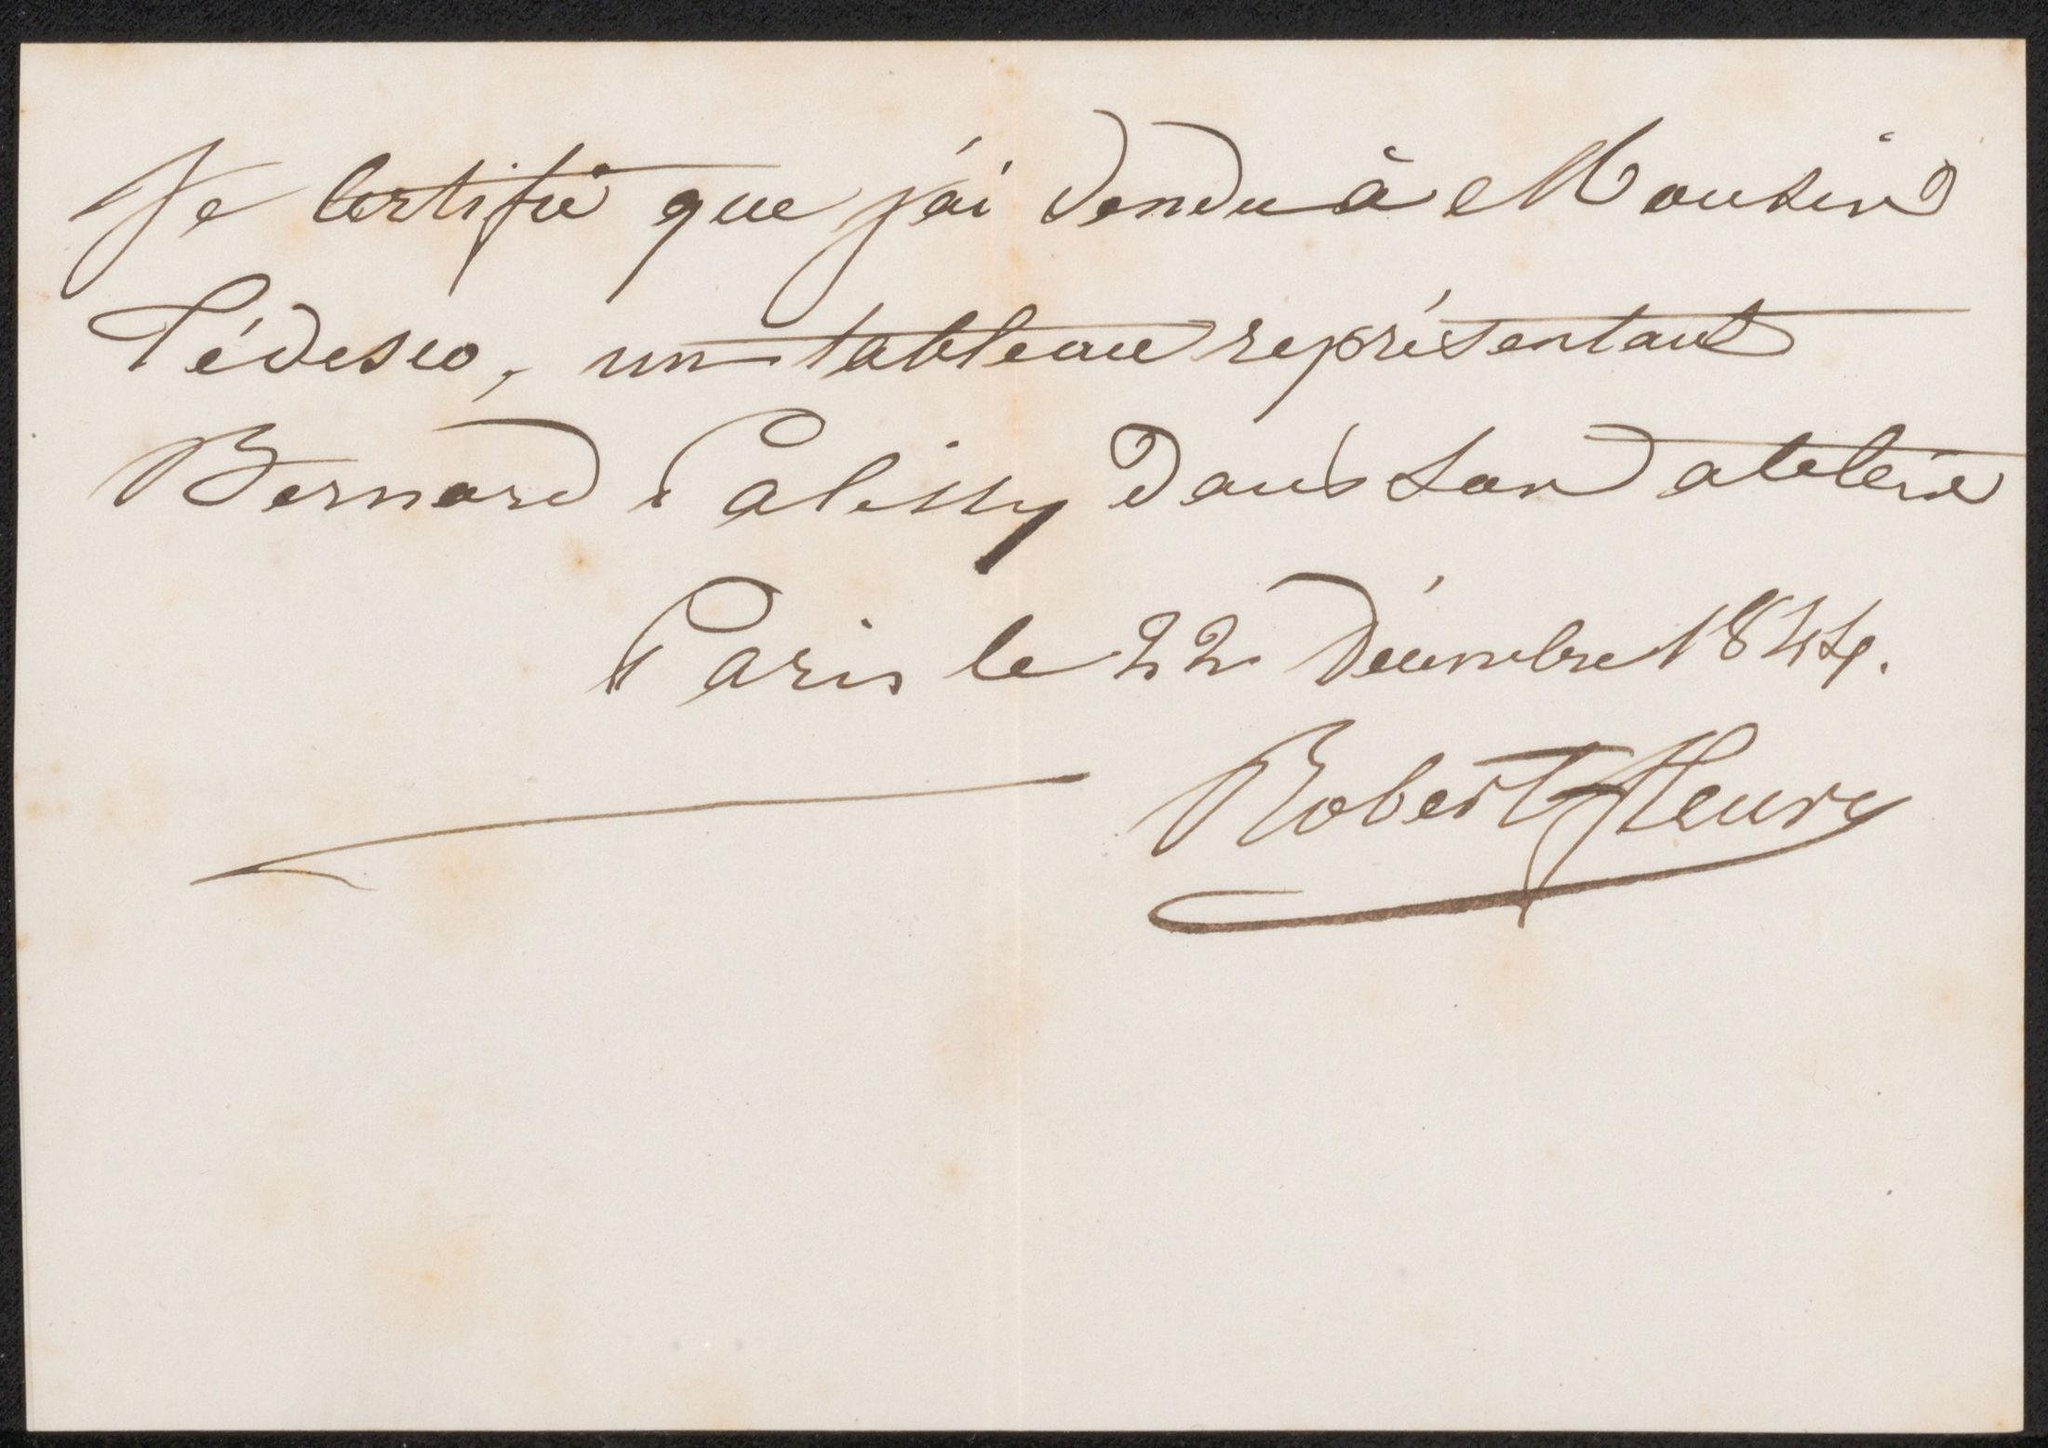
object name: tekst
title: Verklaring betreffende de verkoop van een schilderij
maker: joseph nicolas robert-fleury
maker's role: draughtsman, painter, print maker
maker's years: 1797-1890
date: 1844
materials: ink, paper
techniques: pen, writing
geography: paris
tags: paris, painter, art trade, art shop, painting (including book-illumination, miniature-painting), workshop, studio of the artist (in general), historical persons (portraits and scenes from the life)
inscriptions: collector's mark: Lugt 2228